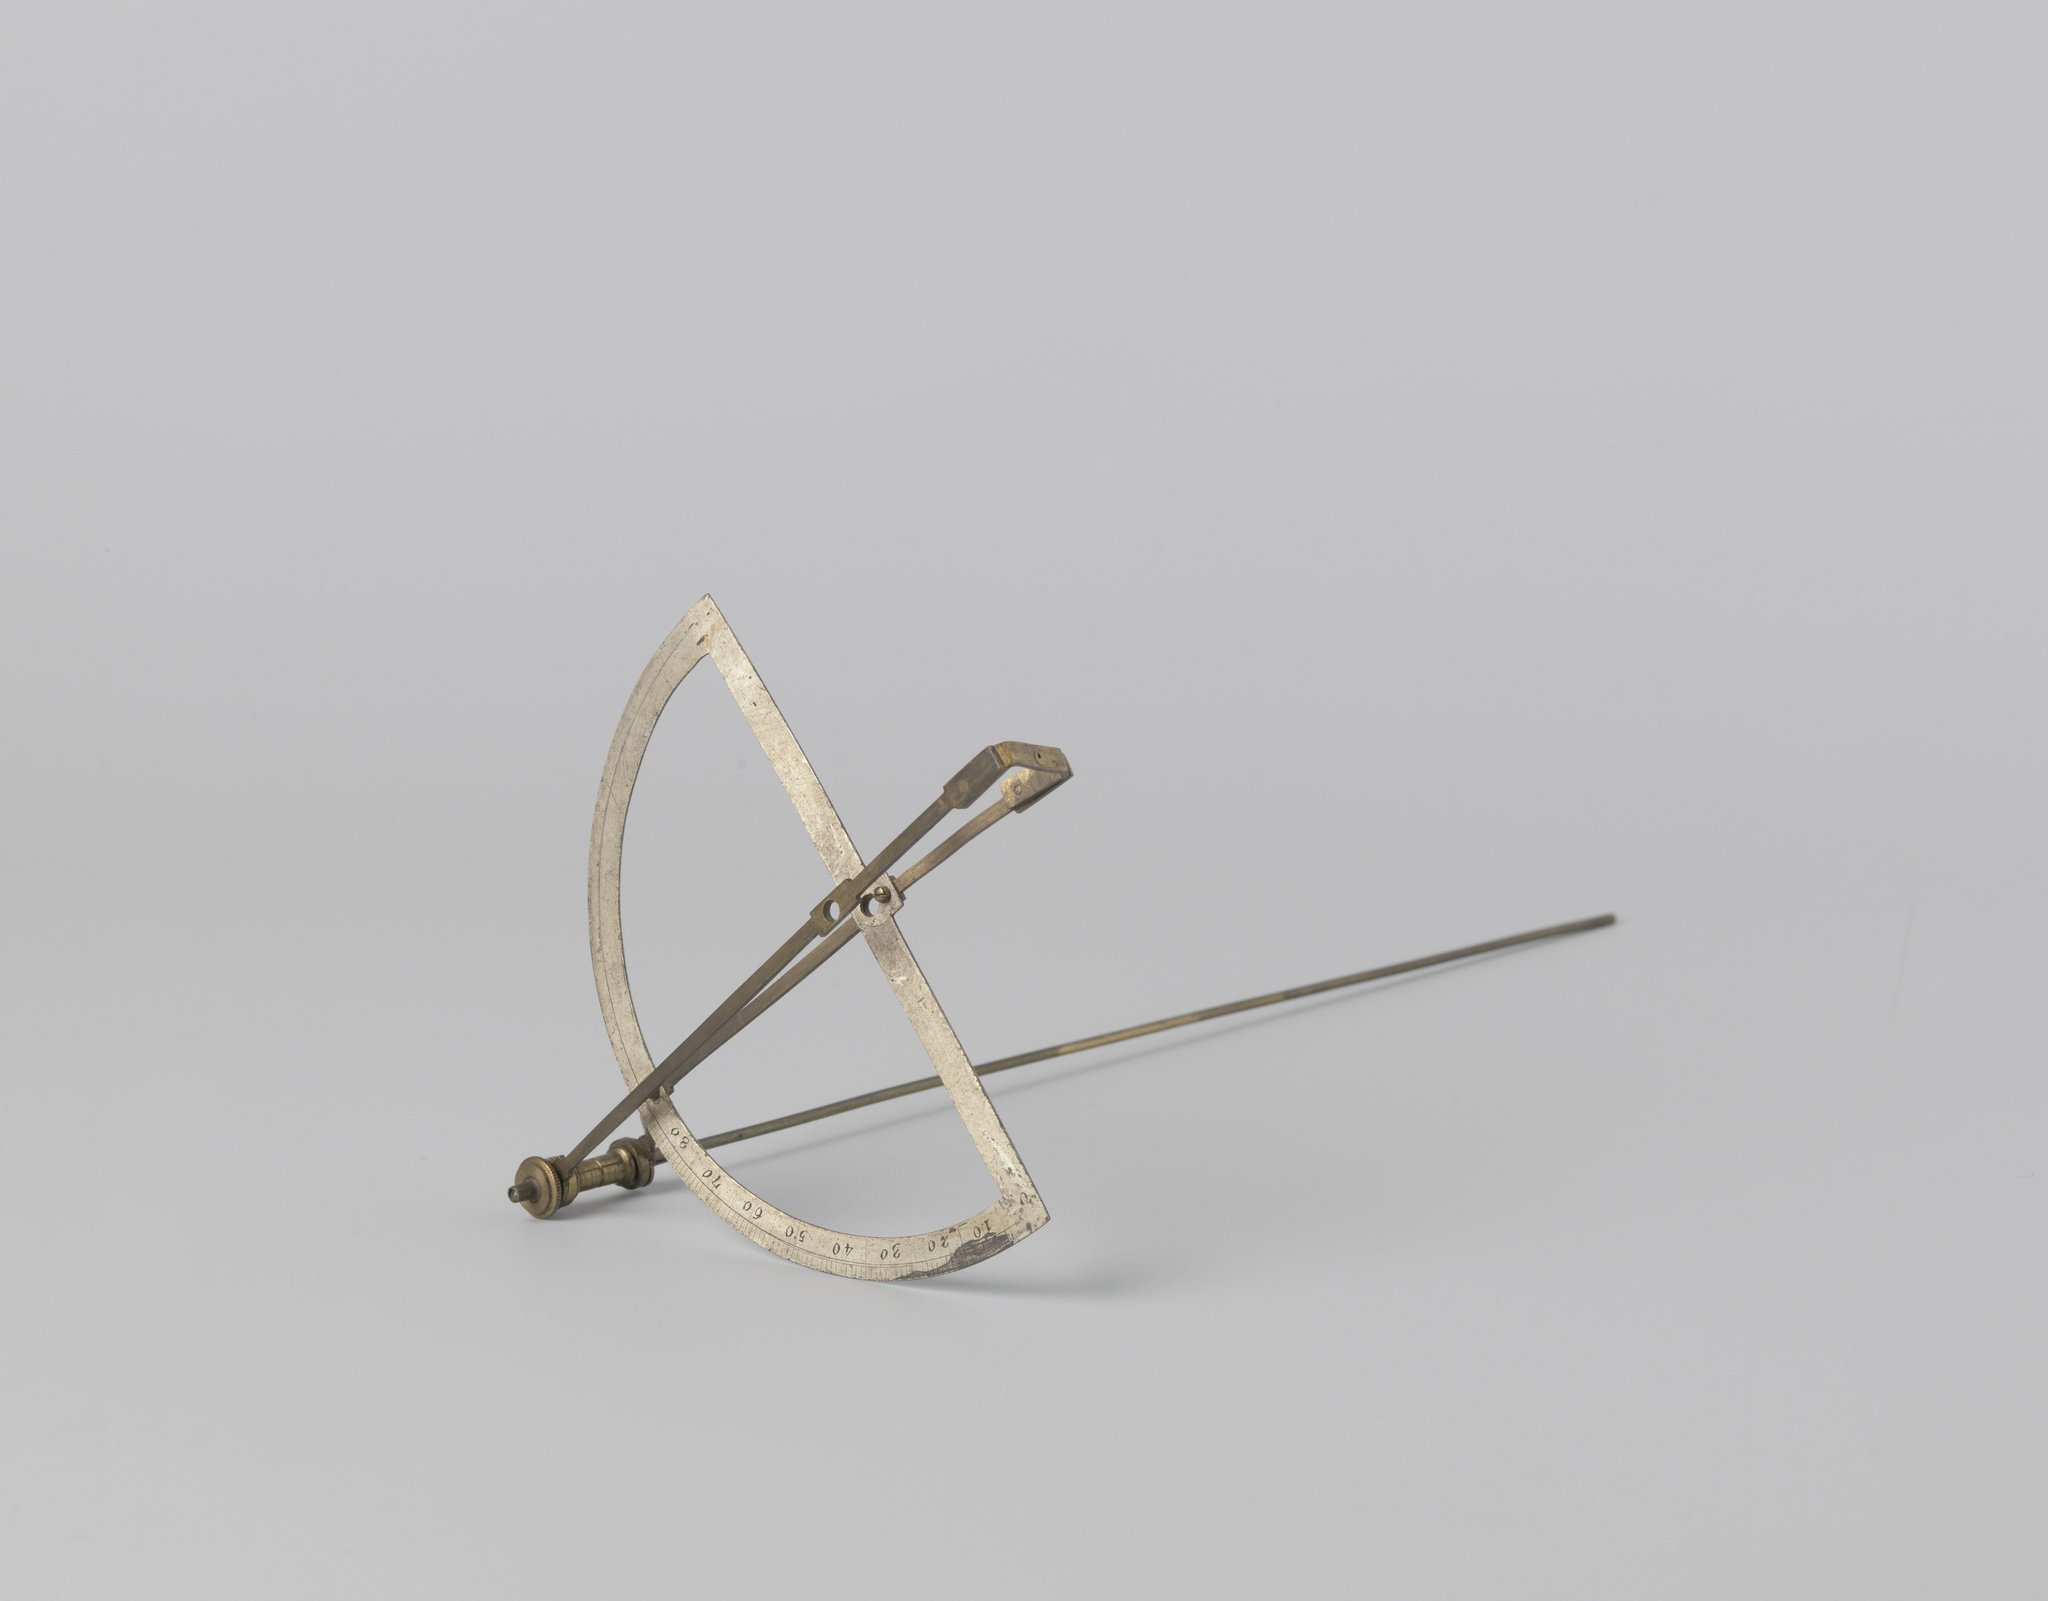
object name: measuring instrument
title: Graadboogje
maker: Anonymous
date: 1850-1900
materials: brass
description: Messing graadboogje aan een lange spil. Aan een zijde gradenboog weergegeven van 0-90, incompleet.